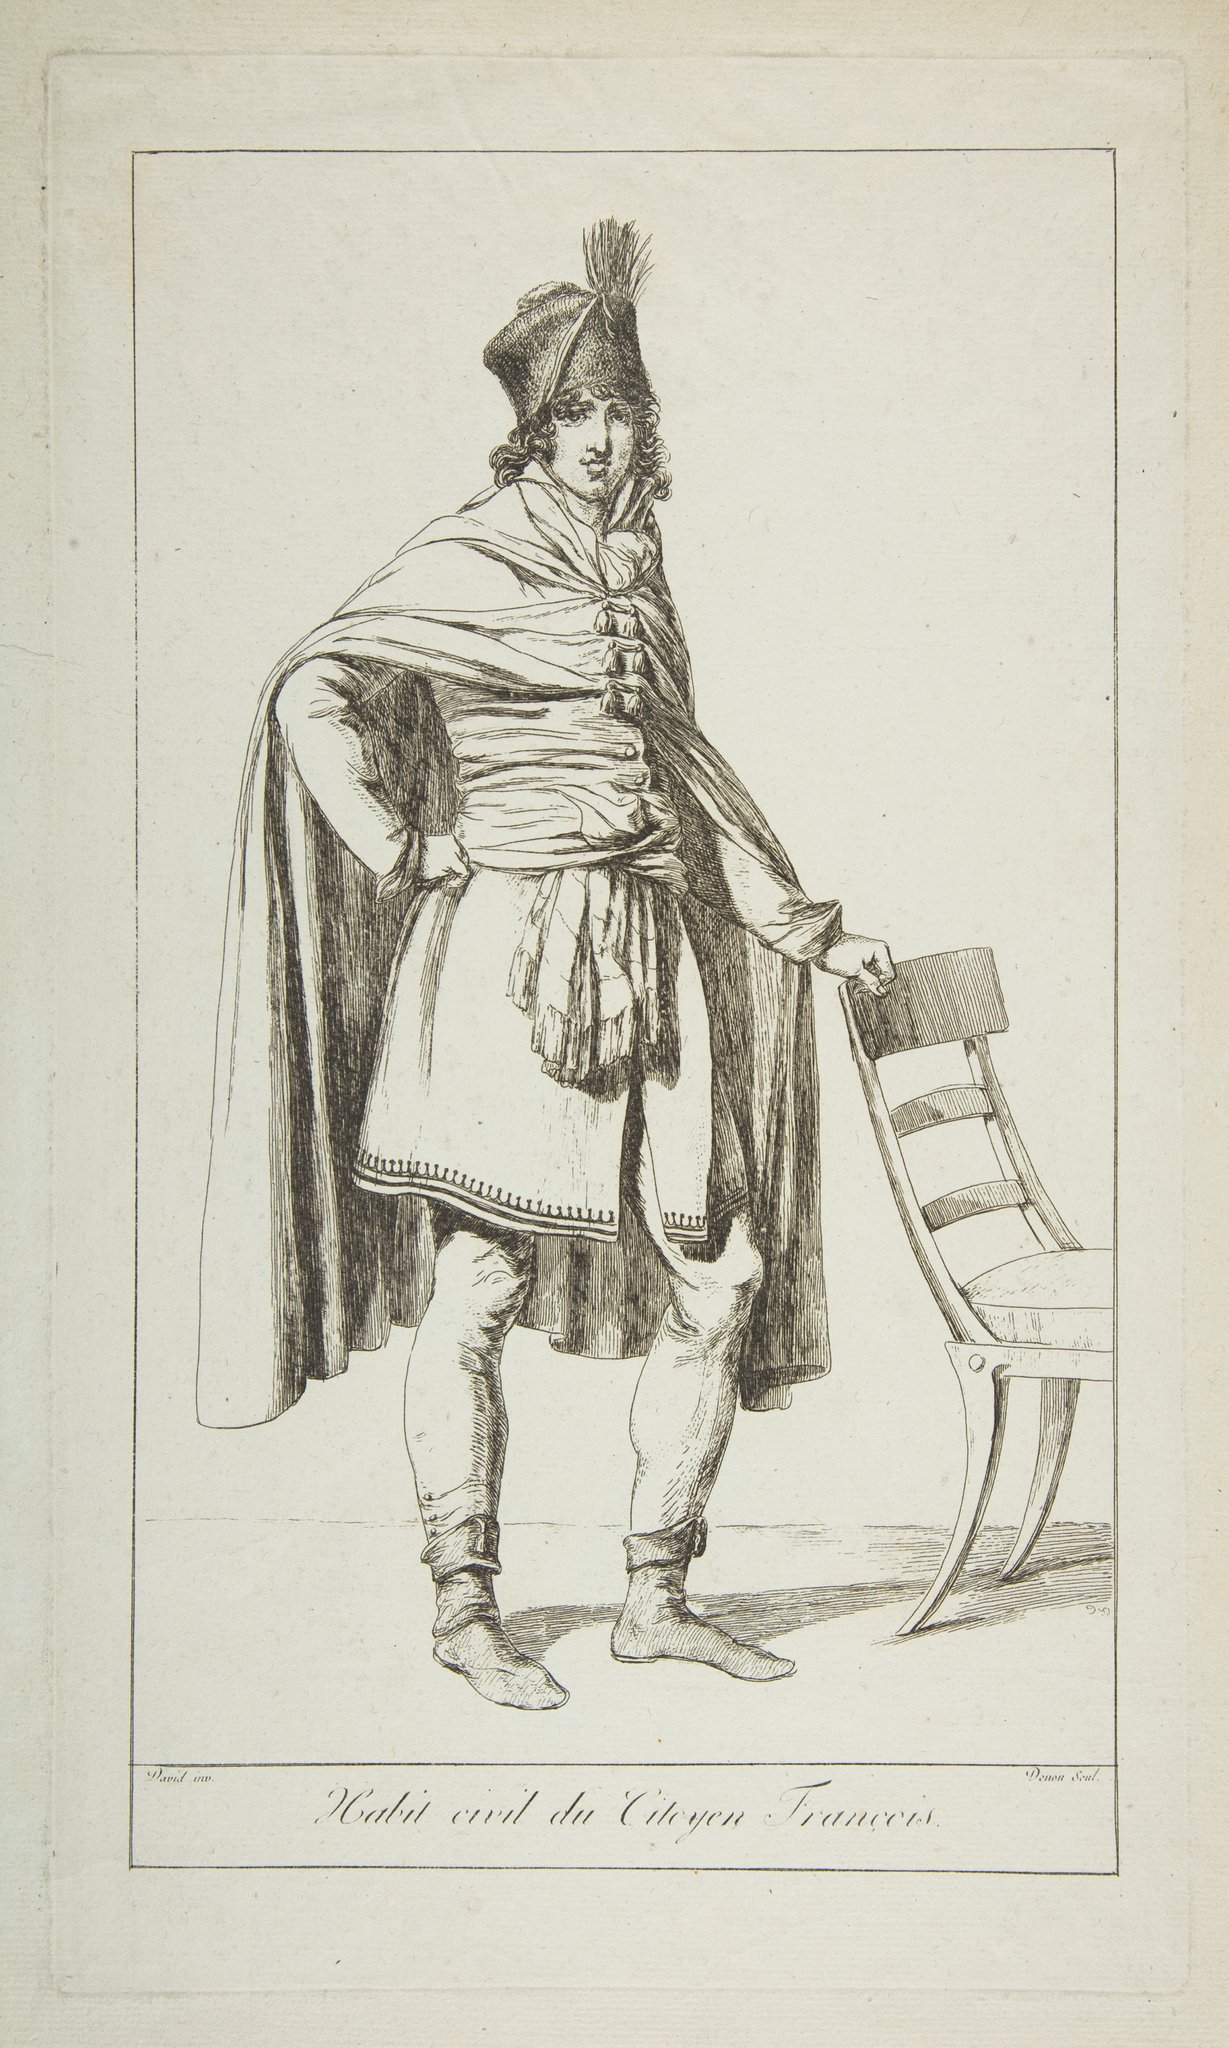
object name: print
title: Civil Garb of the French Citizen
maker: jacques louis david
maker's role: artist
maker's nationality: french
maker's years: 1748-1825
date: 1794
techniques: etching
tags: men